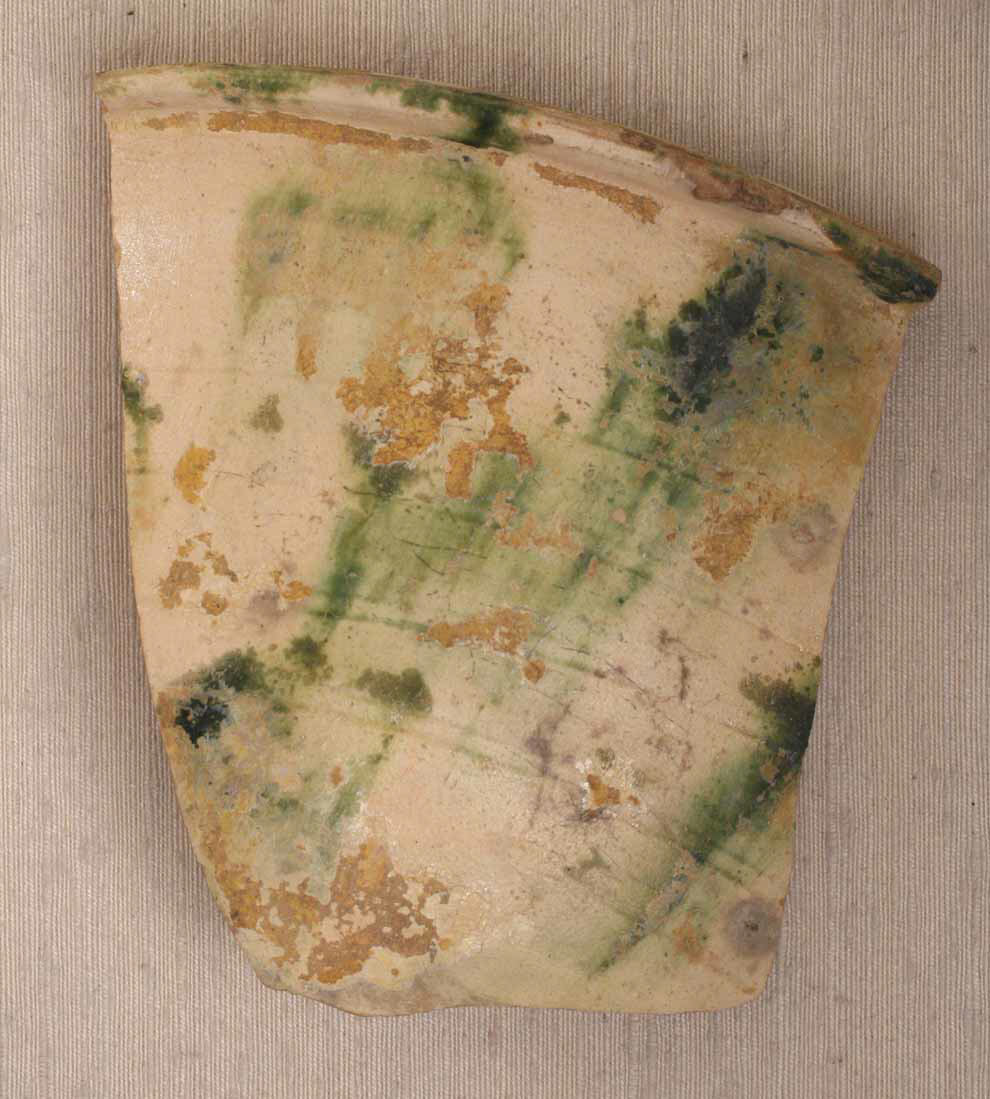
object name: fragment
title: Fragments of Splashed Ceramic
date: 801-900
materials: earthenware, glaze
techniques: painting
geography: iraq